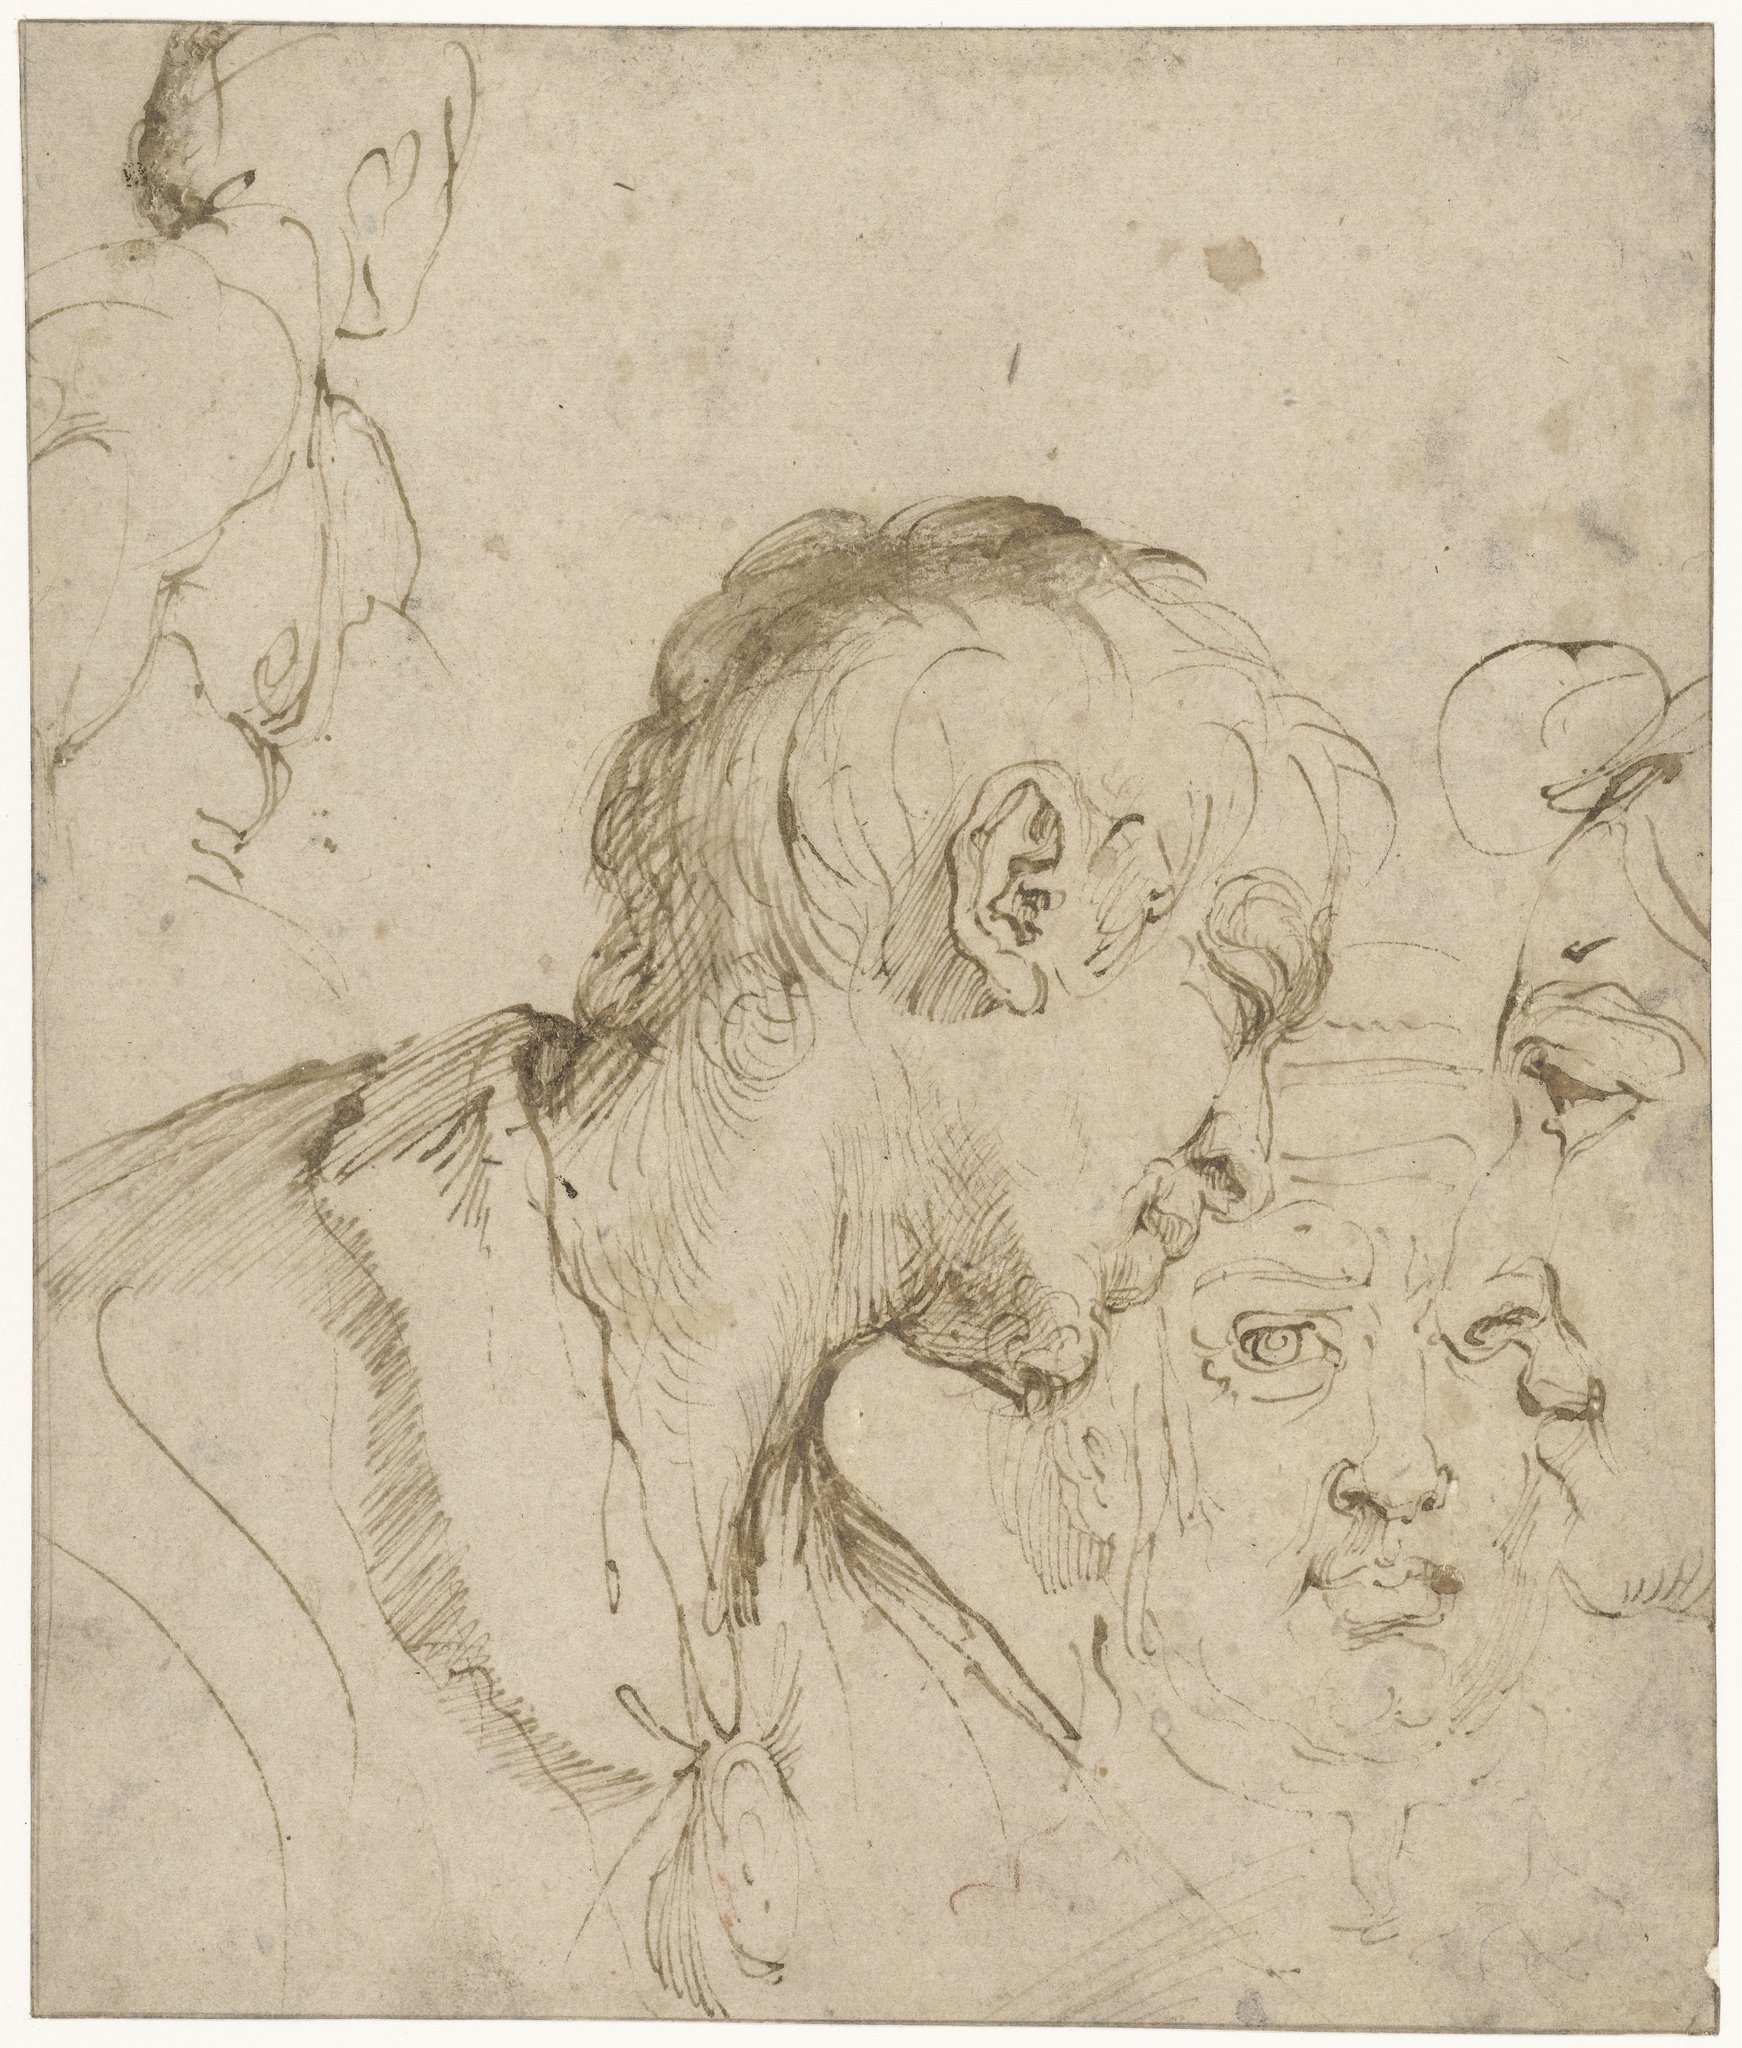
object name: drawing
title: Drie hoofden van mannen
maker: annibale carracci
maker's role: draughtsman, print maker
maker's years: 1560-1609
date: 1592-1602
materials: ink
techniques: brush, pen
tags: head (human), adult man